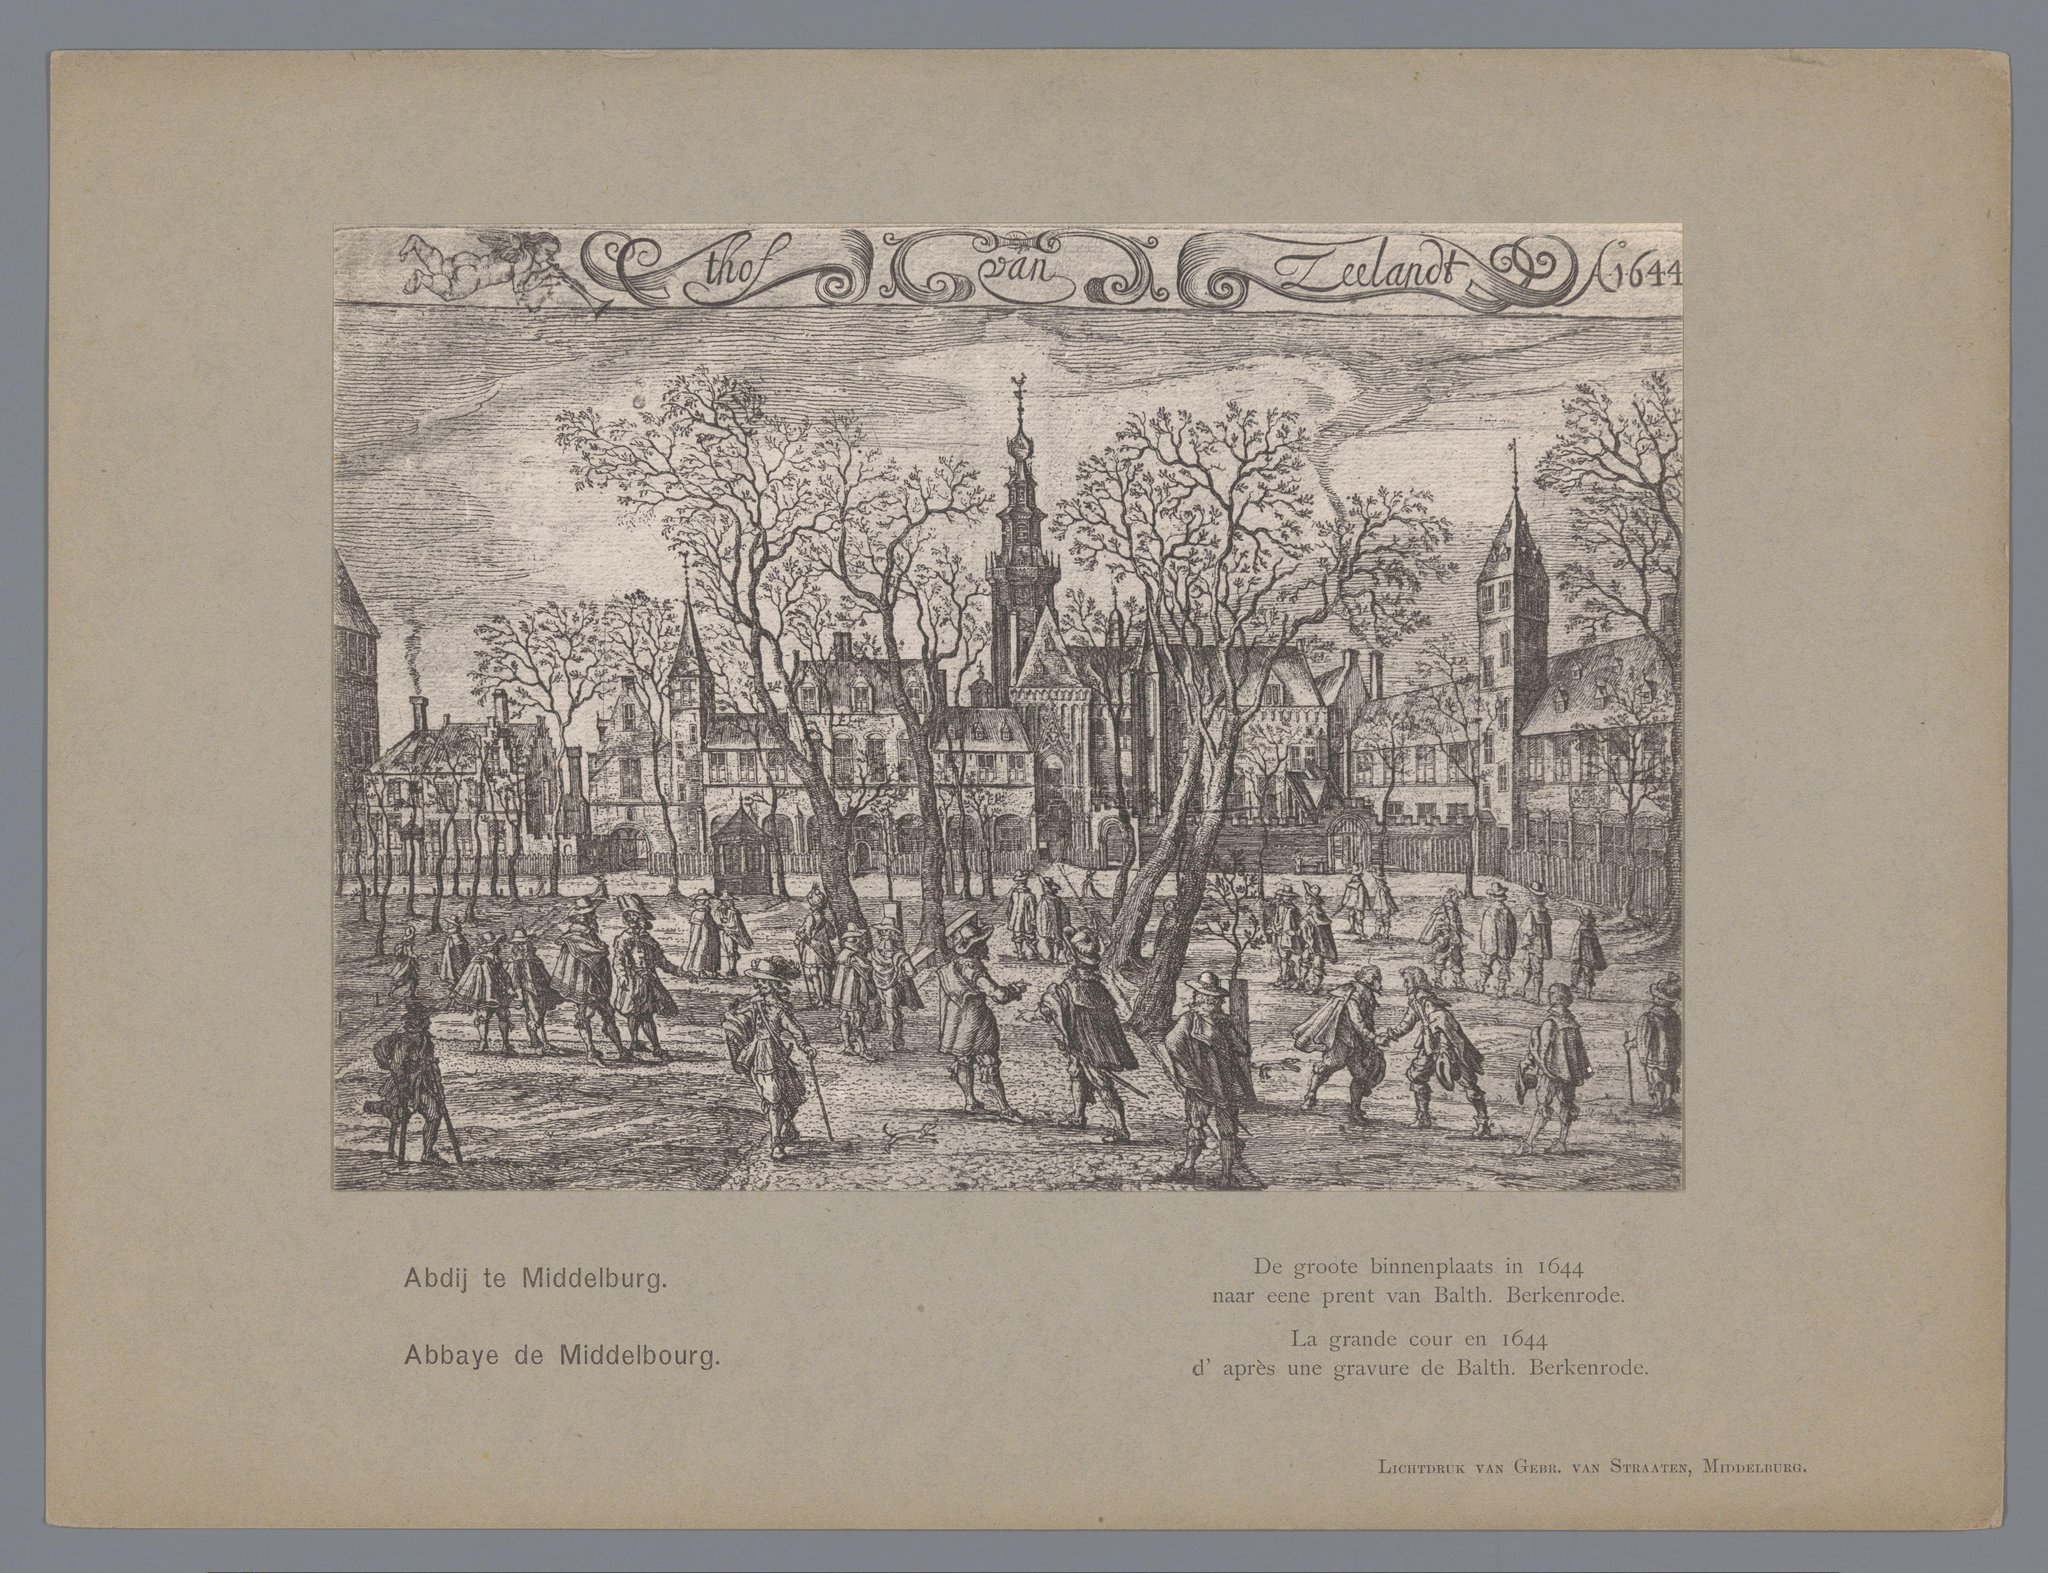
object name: photomechanical print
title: Reproductie van een prent van Balthasar Berckenrode met de binnenplaats van de Abdij te Middelburg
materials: paper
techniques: photograph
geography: middelburg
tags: abbey, monastery, convent ~ roman catholic church, courtyard, abbey garden